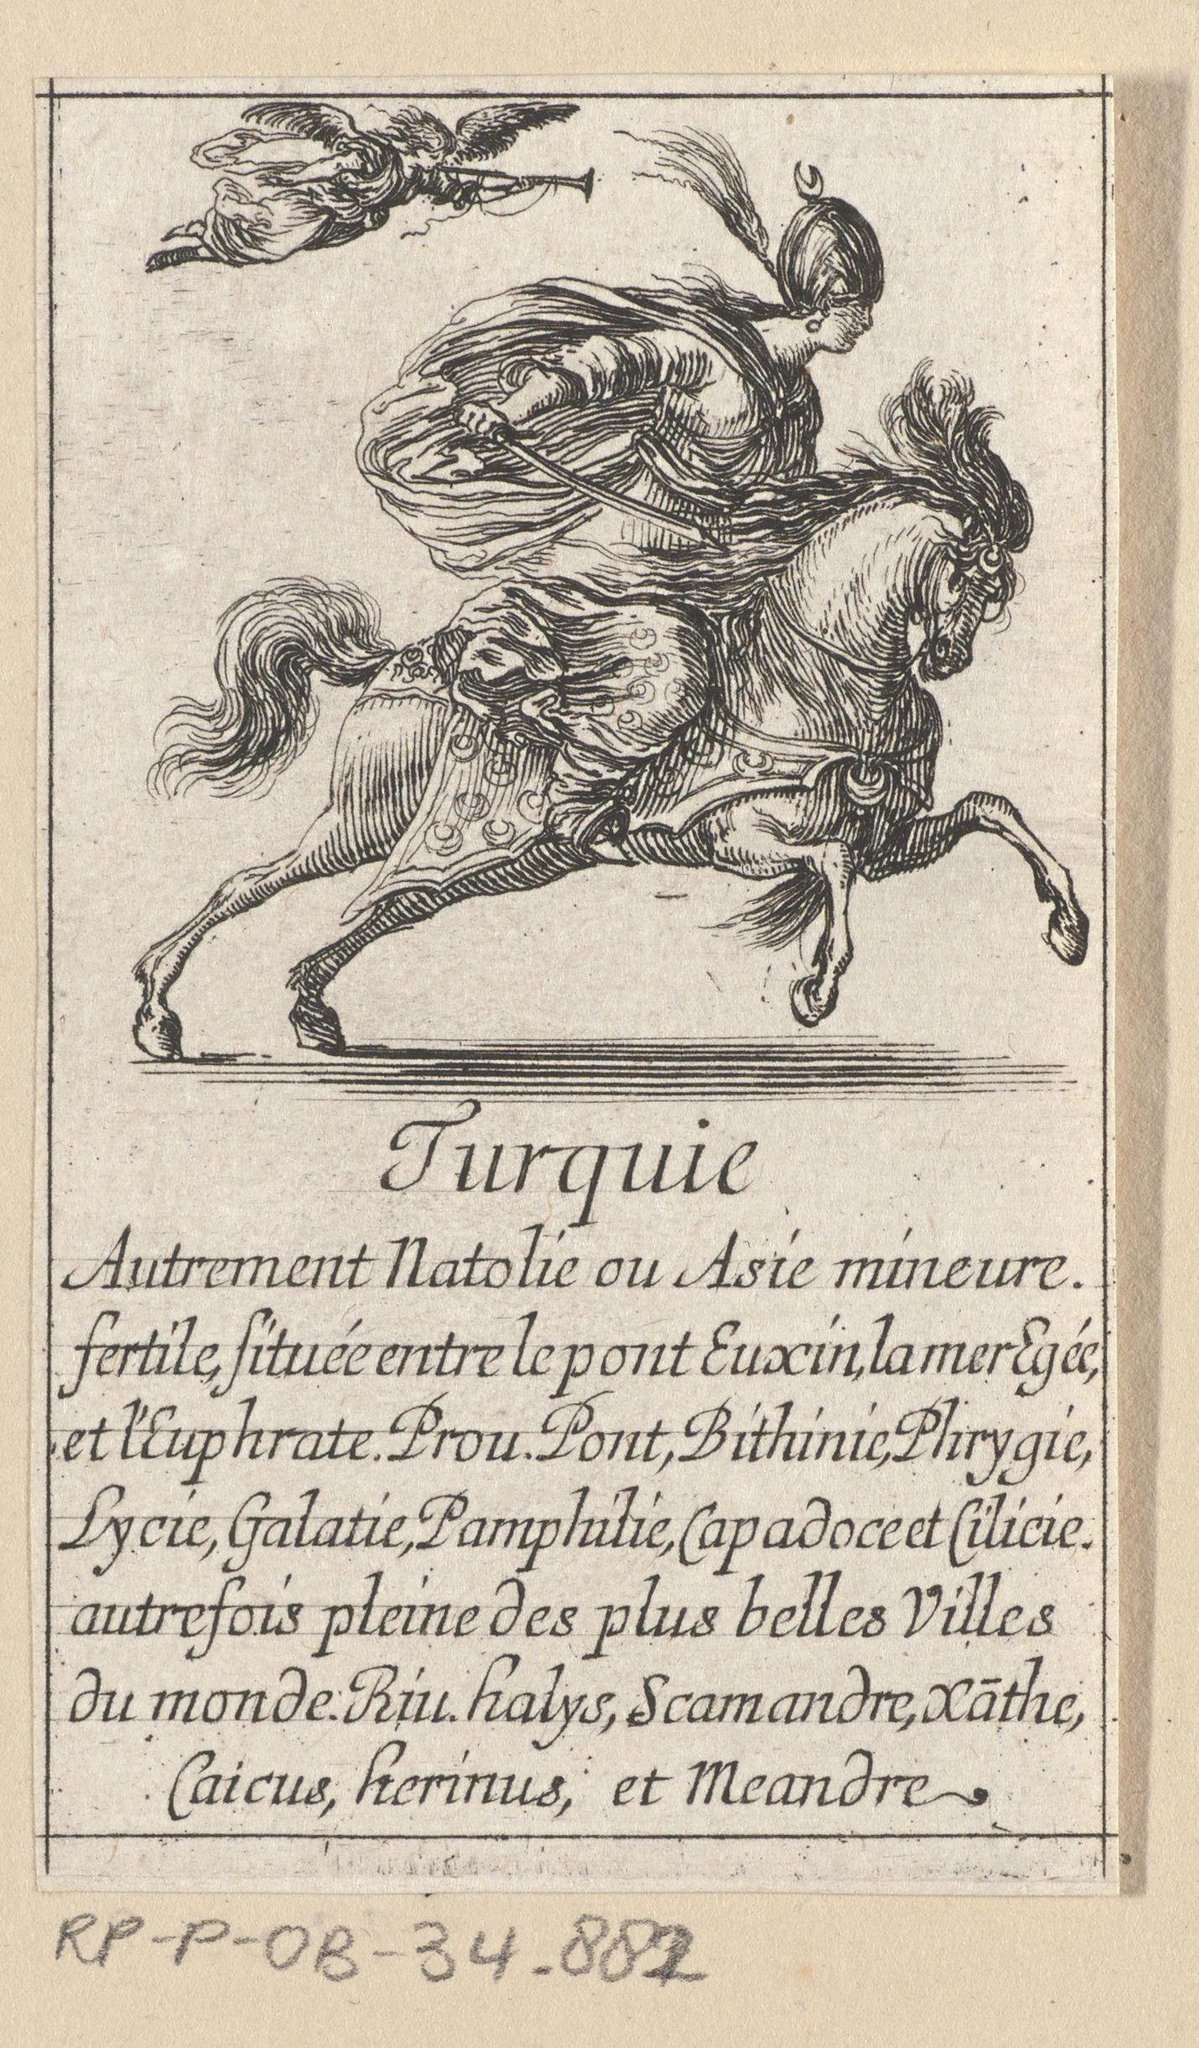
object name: print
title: Kaartspel geografie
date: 1620-1664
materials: paper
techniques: etching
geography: paris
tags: riding a horse, ass, or mule; rider, horseman, asiatic races and peoples (+ costume), horse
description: Deze prent maakt deel uit van een kaartspel met 52 kaarten met voorstellingen van vrouwen uit landen over de hele wereld. De serie is uitgedacht door Jean Desmarests de Saint-Sorlin in opdracht van Kardinaal Mazarin. Het kaartspel werd gemaakt voor de jonge Lodewijk XIV, samen met het Jeu des Fables, Jeu des Reynes Renommées en Jeu des Rois de France.